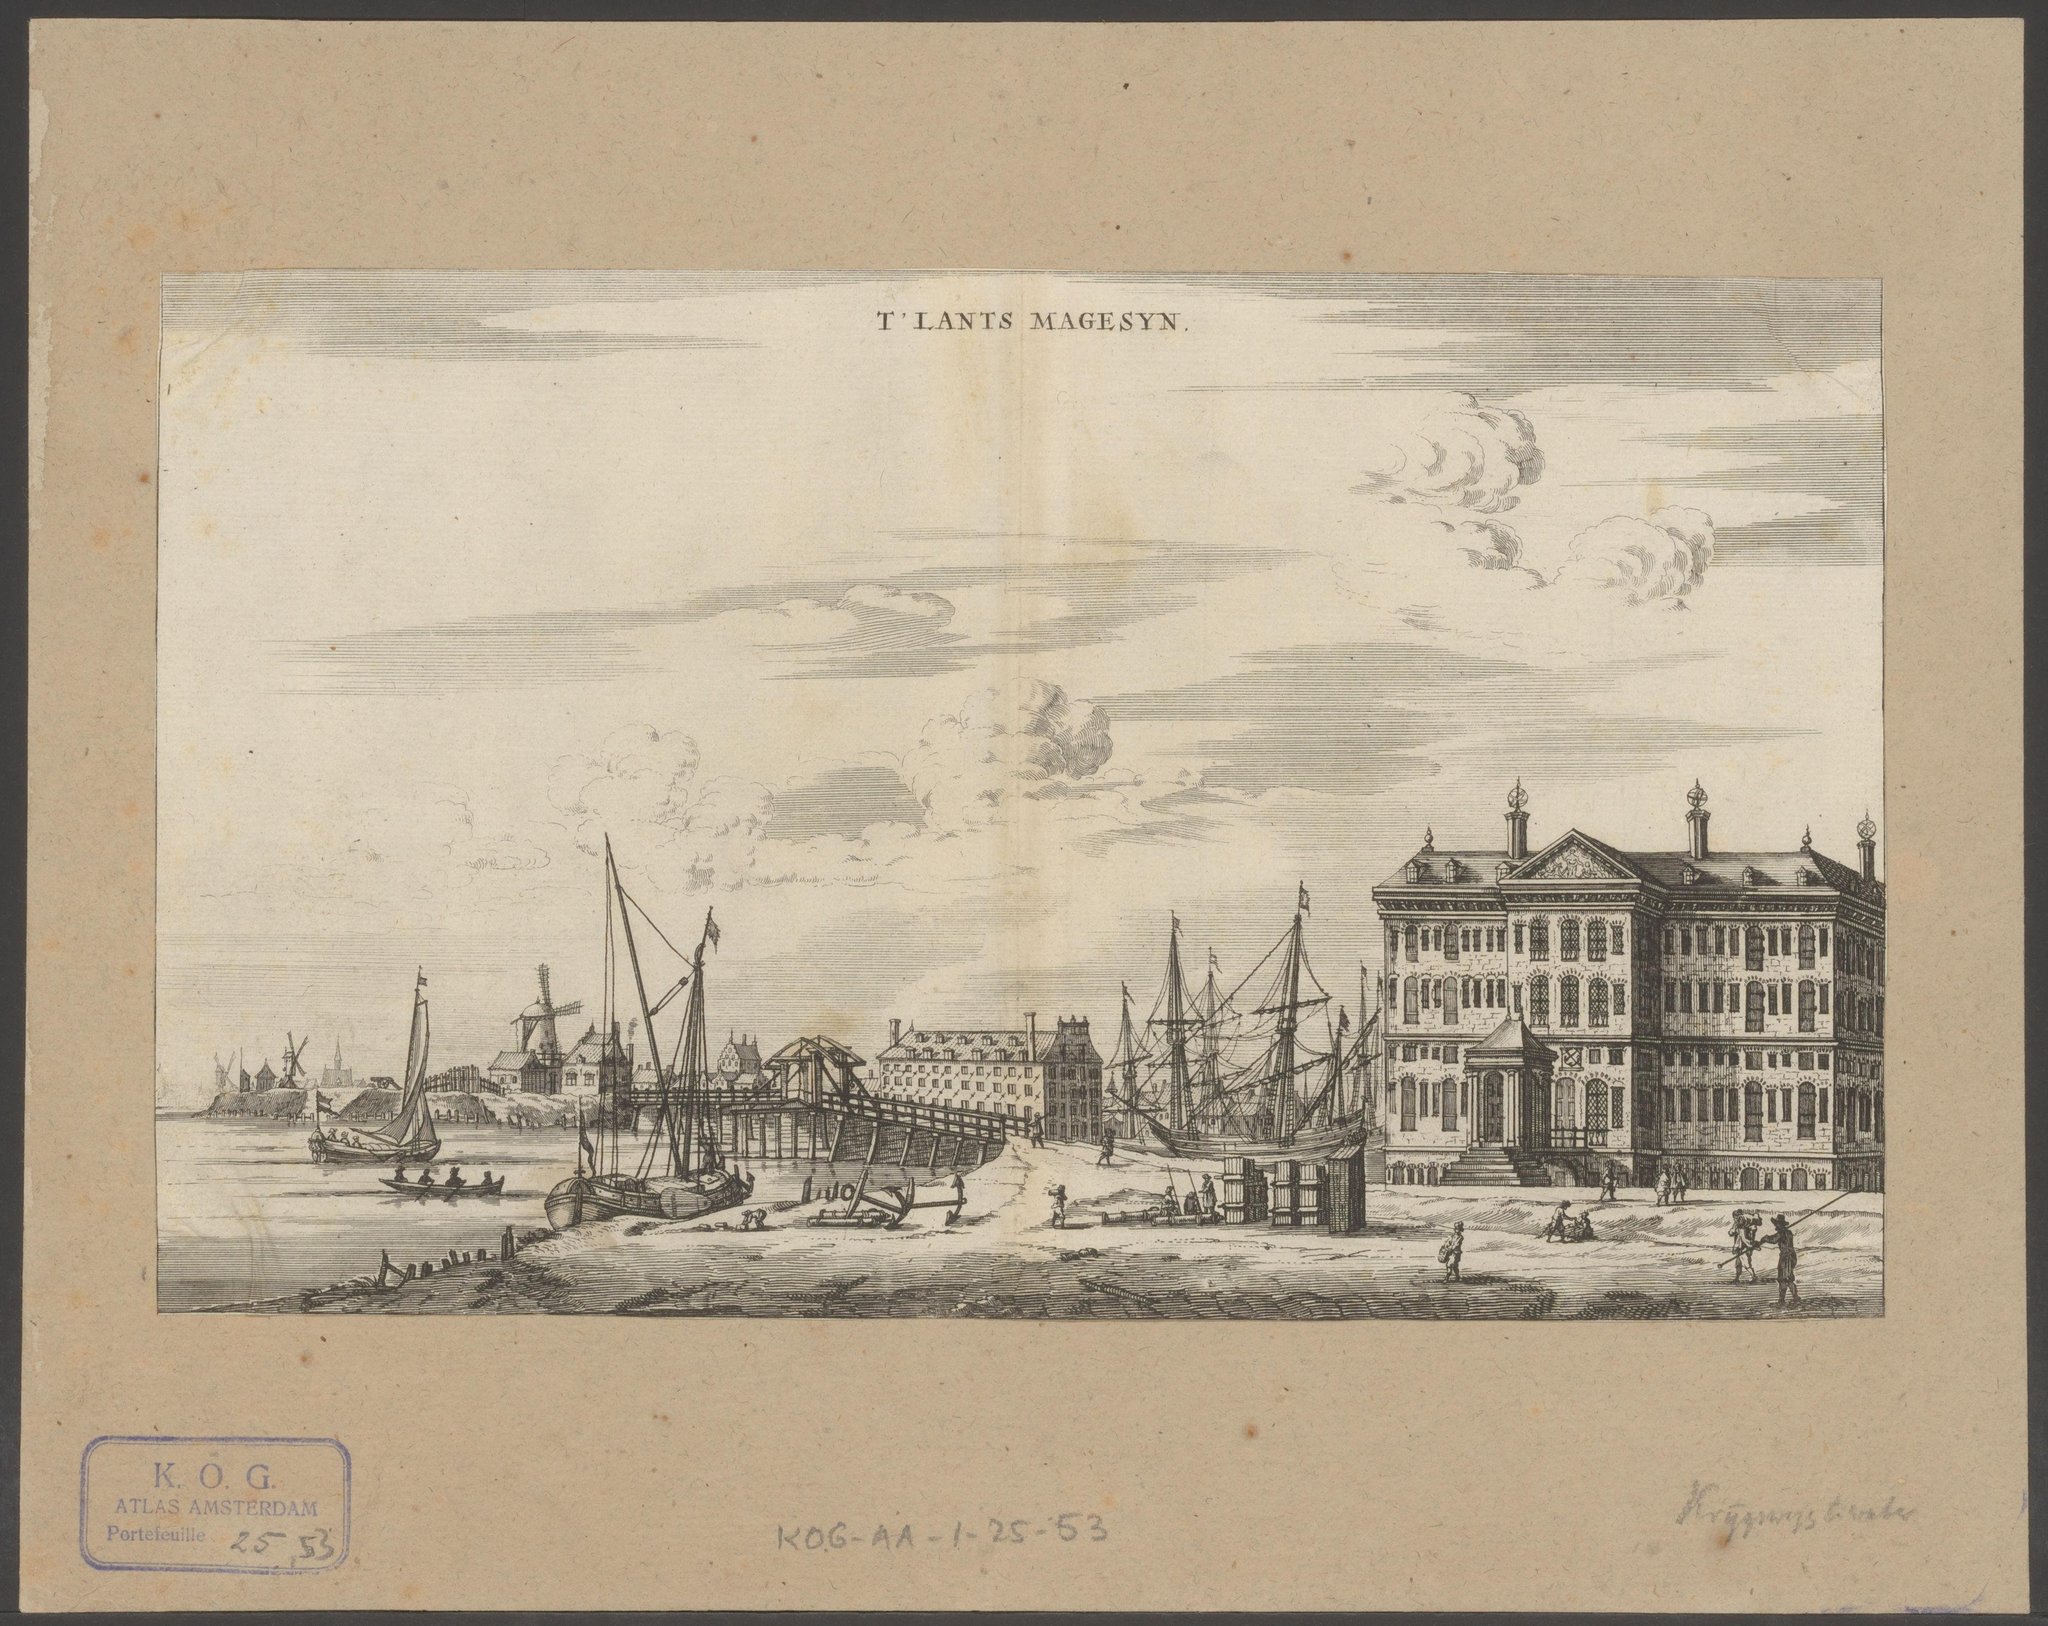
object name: print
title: Gezicht op 's Lands Zeemagazijn (Admiraliteitsmagazijn) te Amsterdam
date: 1663-1664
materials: paper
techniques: engraving, etching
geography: amsterdam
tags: large-scale structure for storage, e.g.: warehouse, depot, silo, ammunition store, arsenal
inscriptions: collector's mark: ‘25.53’ Lugt 1641b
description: Huidige staat van prent mogelijk ook gebruikt in: Dapper, Olfert. Historische beschryving der stadt Amsterdam: waer in de voornaemste geschiedenissen (na een kort verhael van gansch Hollant en d'omleggende dorpen (…). Amsterdam: Jacob van Meurs, 1663.* En in: Zesen, Philipp von. Beschreibung der Stadt Amsterdam: darinnen von derselben ersten Ursprunge bis auf gegenwärtigen Zustand (…). Amsterdam: Joachim Nosche, 1664. * In sommige exemplaren van deze uitgave komt de huidige staat van de prent voor. In andere exemplaren is een latere staat ingebonden, waarop boven de Nederlandse een Franse titel is toegevoegd.